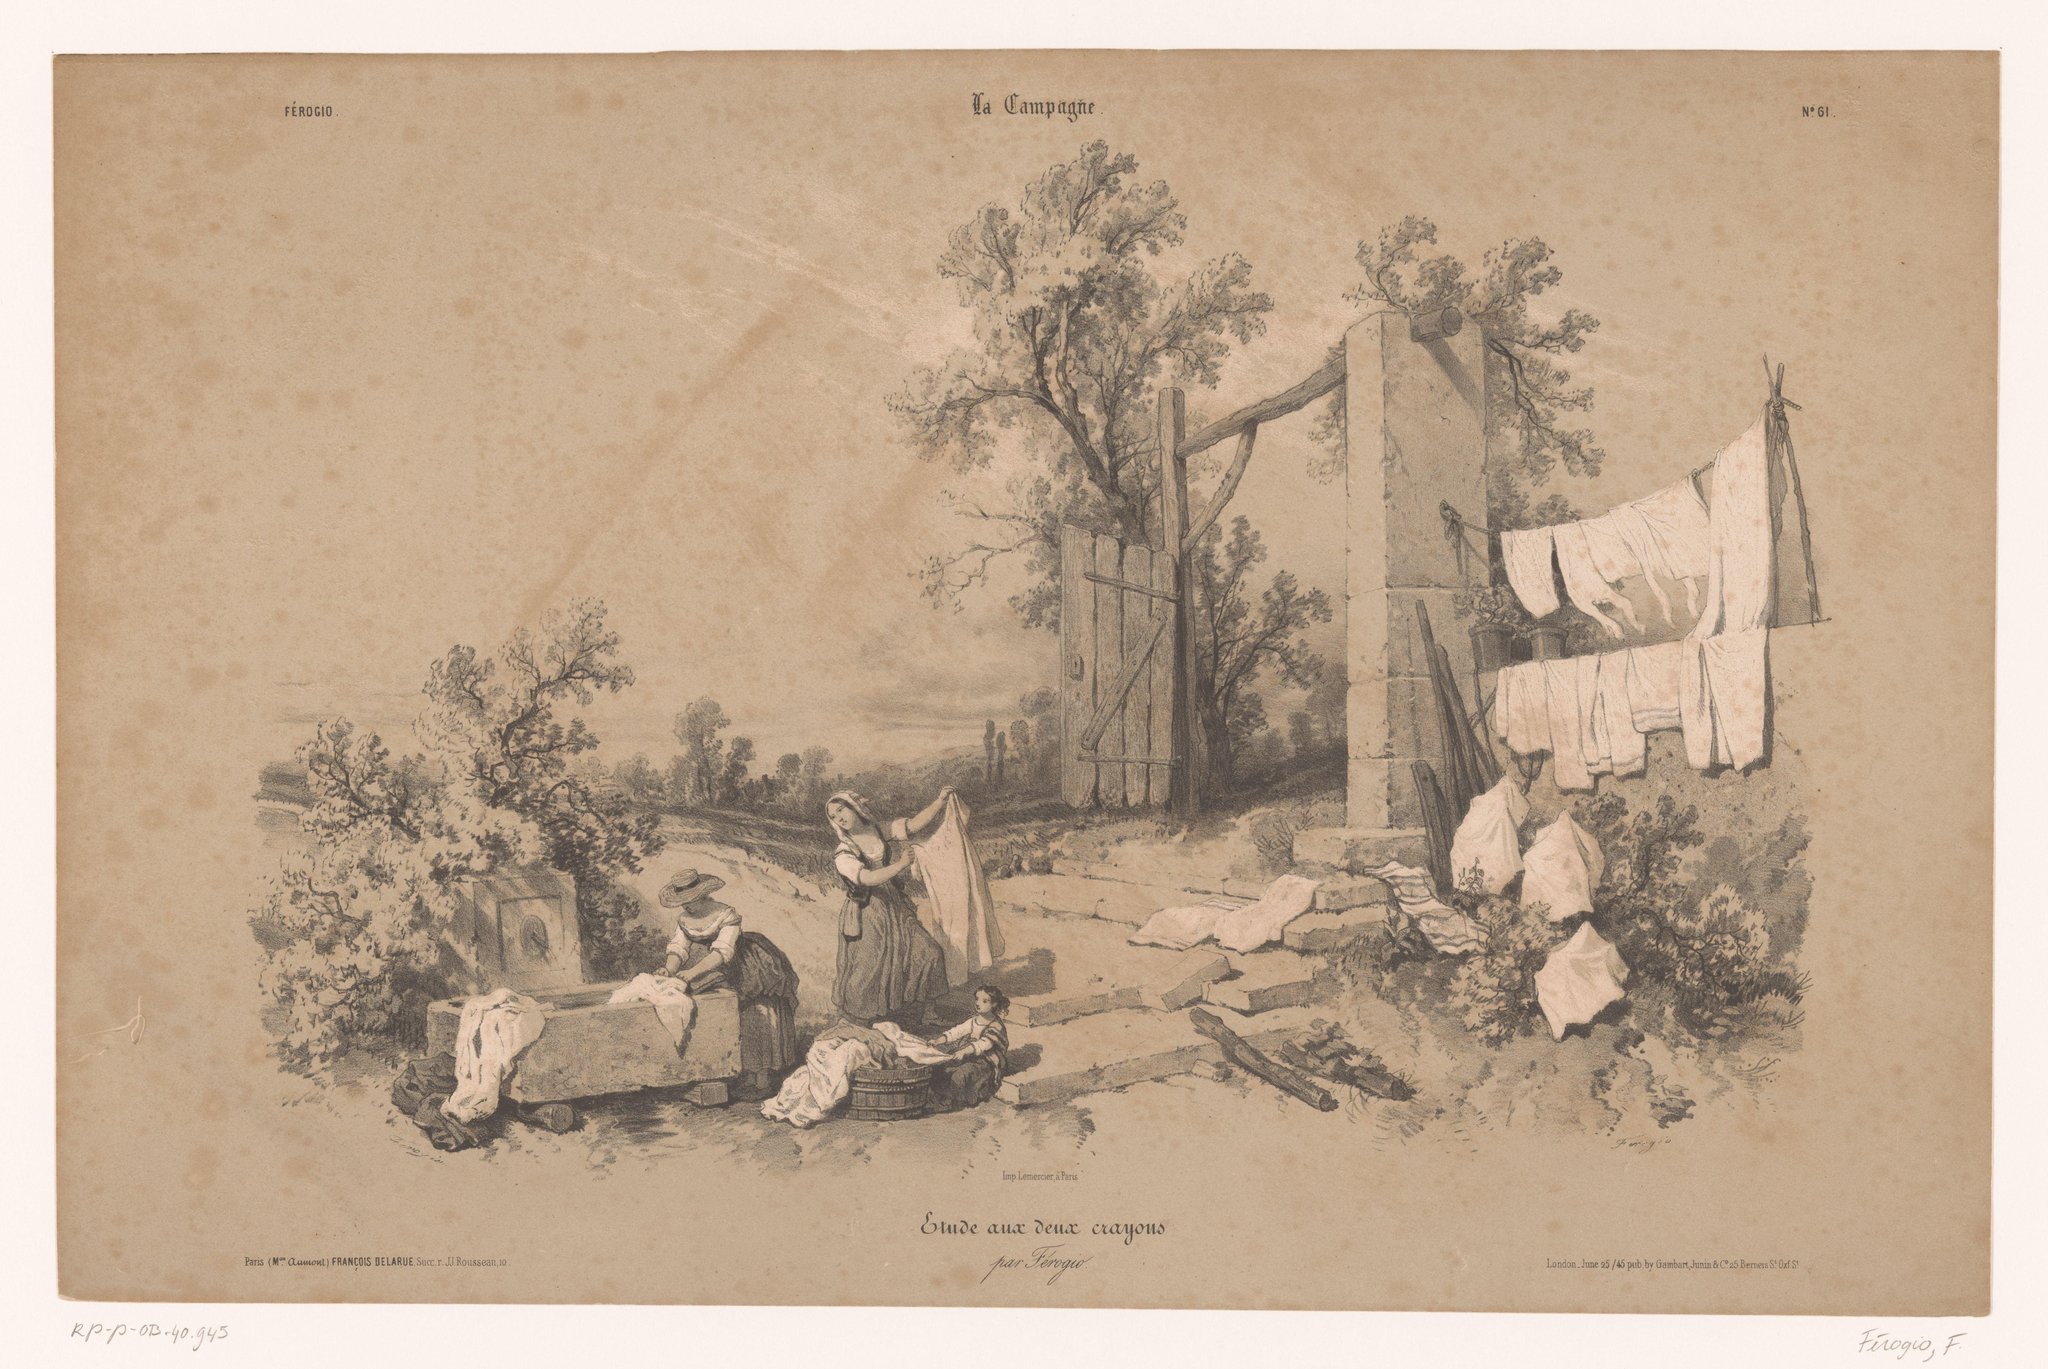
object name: print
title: Twee vrouwen en een kind doen de was in de open lucht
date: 1853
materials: paper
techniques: lithography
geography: paris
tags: gate, entrance, hanging the wash to dry